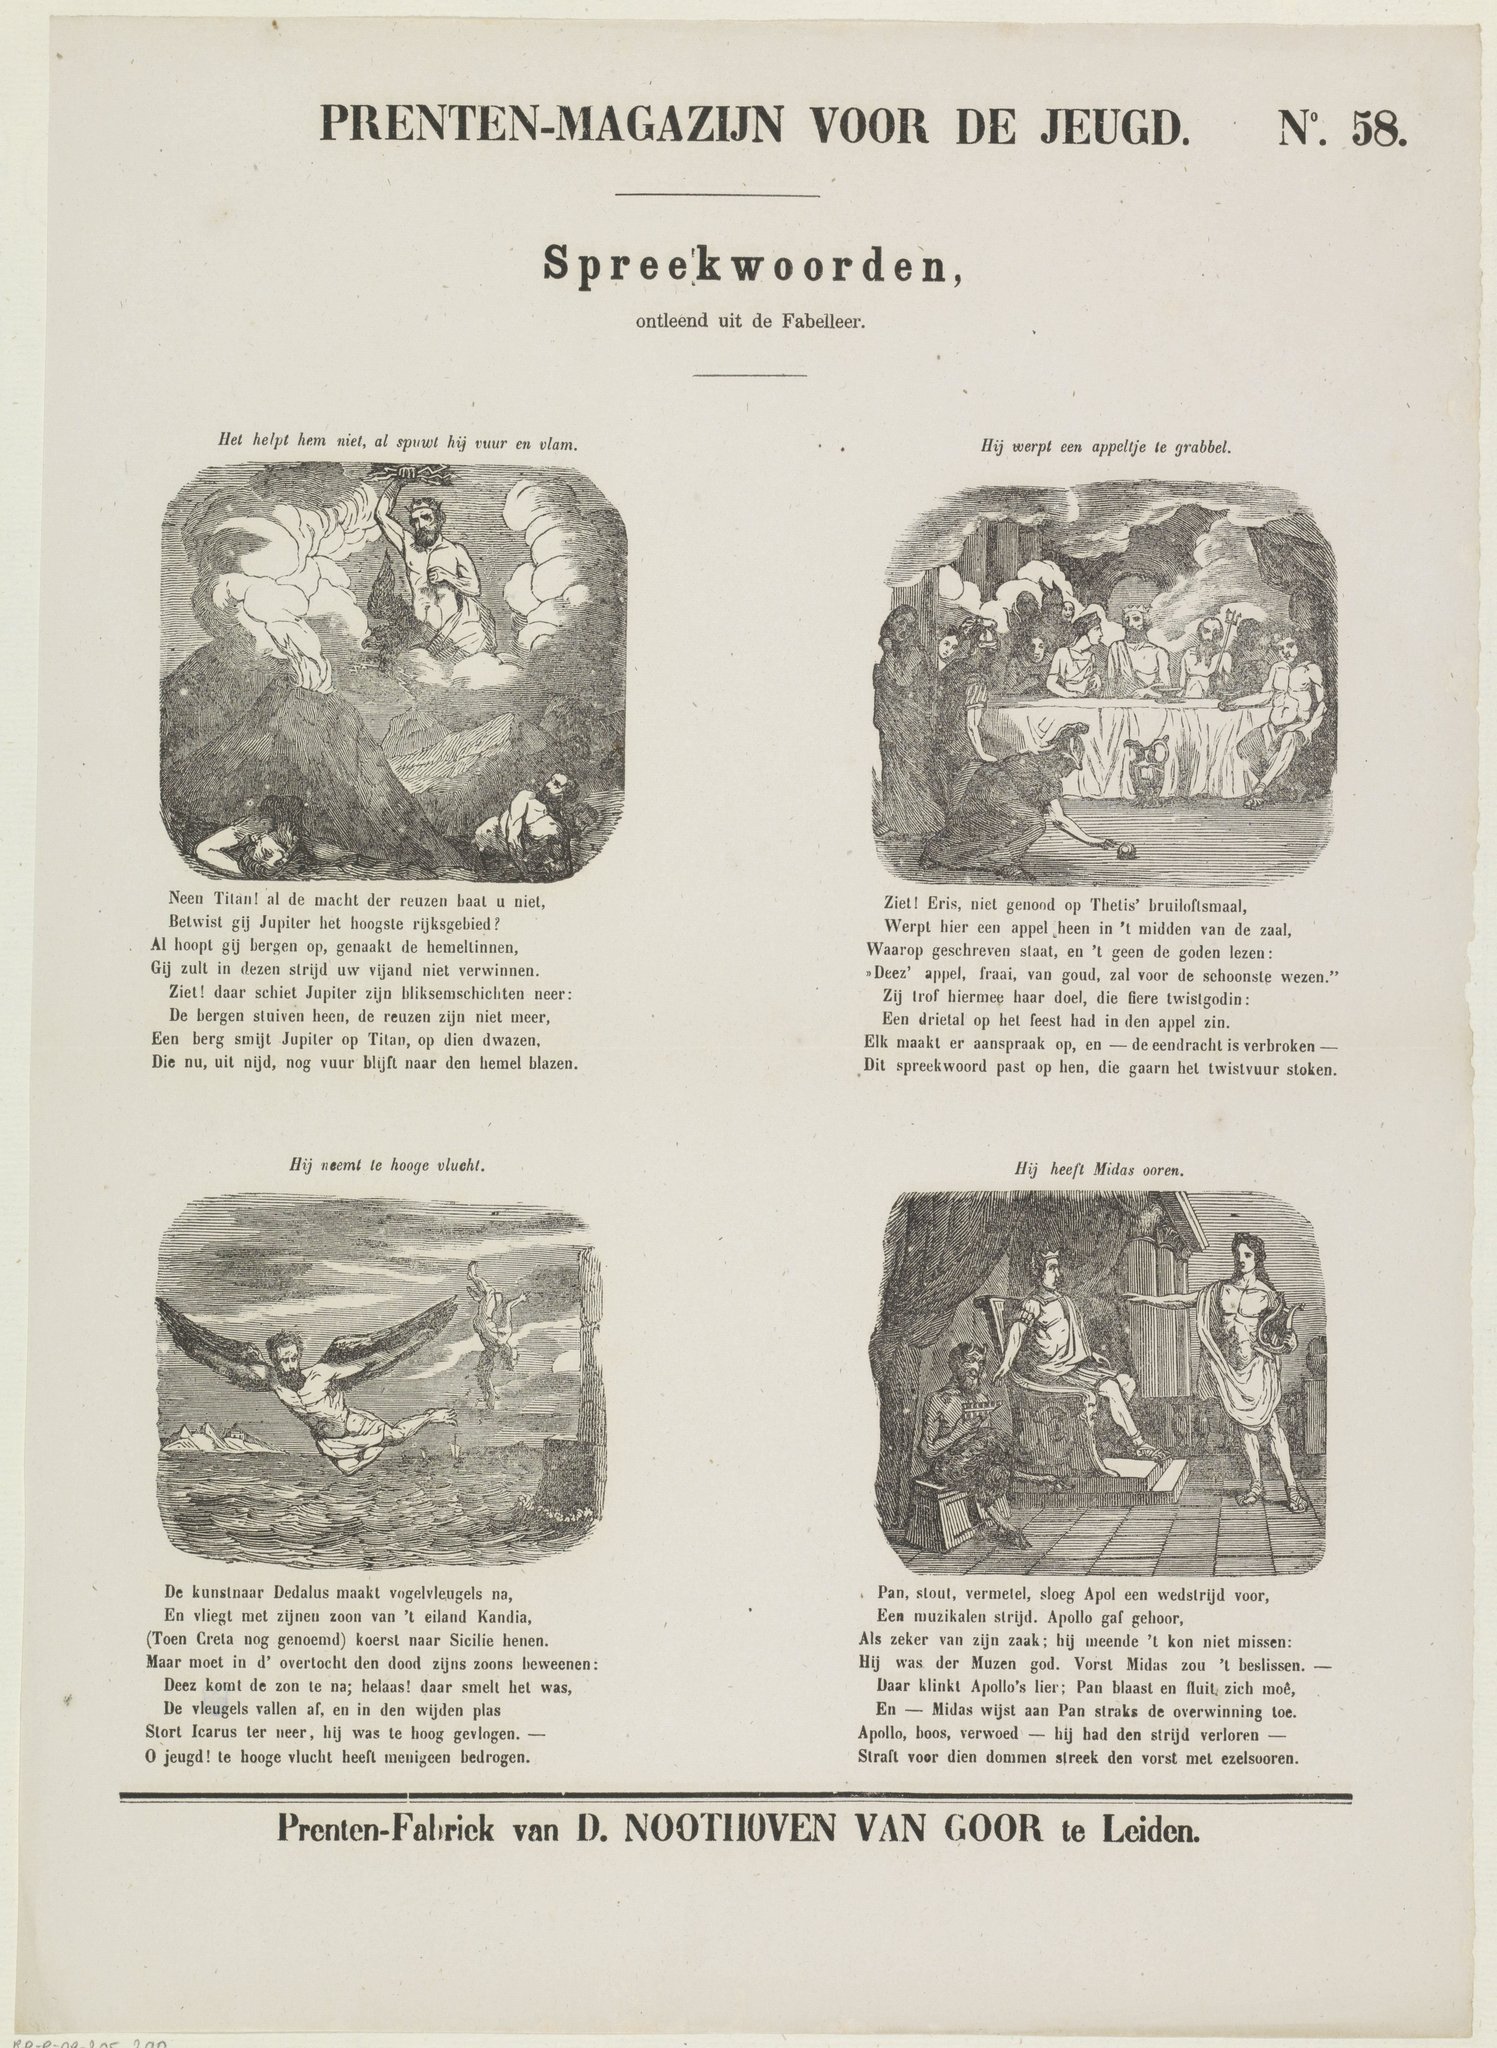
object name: popular print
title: Spreekwoorden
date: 1850-1881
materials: paper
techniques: letterpress printing, engraving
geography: leiden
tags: war of the titans against jupiter and allies: titanomachy, (story of) icarus, son of daedalus, proverbs, sayings, etc., eris throws the golden apple, classical mythology and ancient history, midas given ass's ears: apollo gives midas ass's ears as punishment for preferring pan in the musical contest between apollo and pan (ovid, metamorphoses xi 174)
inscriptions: collector's mark: Lugt 2760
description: Blad met 4 verbeeldingen van spreekwoorden, gebaseerd op mythologische verhalen. Boven elke voorstelling een titel en onder elke voorstelling een achtregelig vers. Genummerd rechtsboven: No. 58.